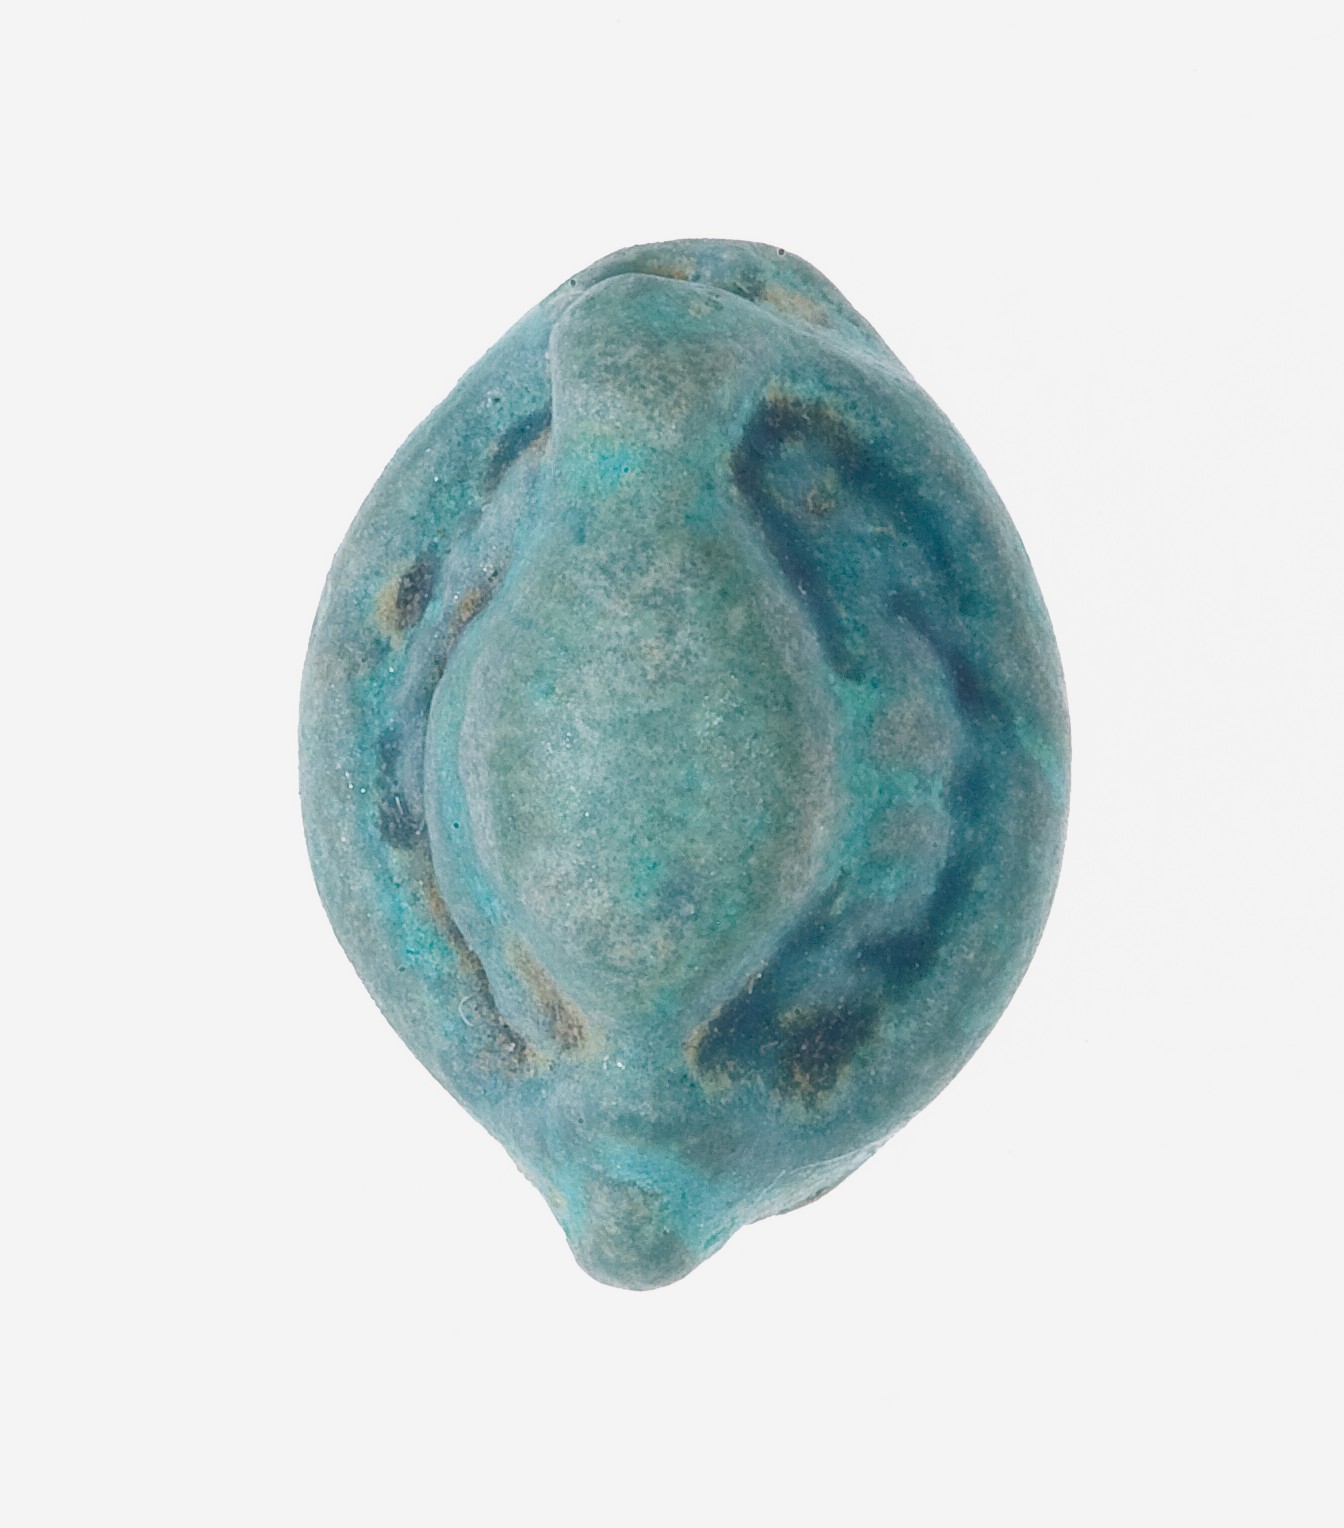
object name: cowroid, seal amulet, design amulet, maat feather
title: Seal Amulet in the Shape of a Cowry Shell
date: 1390-1352 BCE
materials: faience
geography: egypt